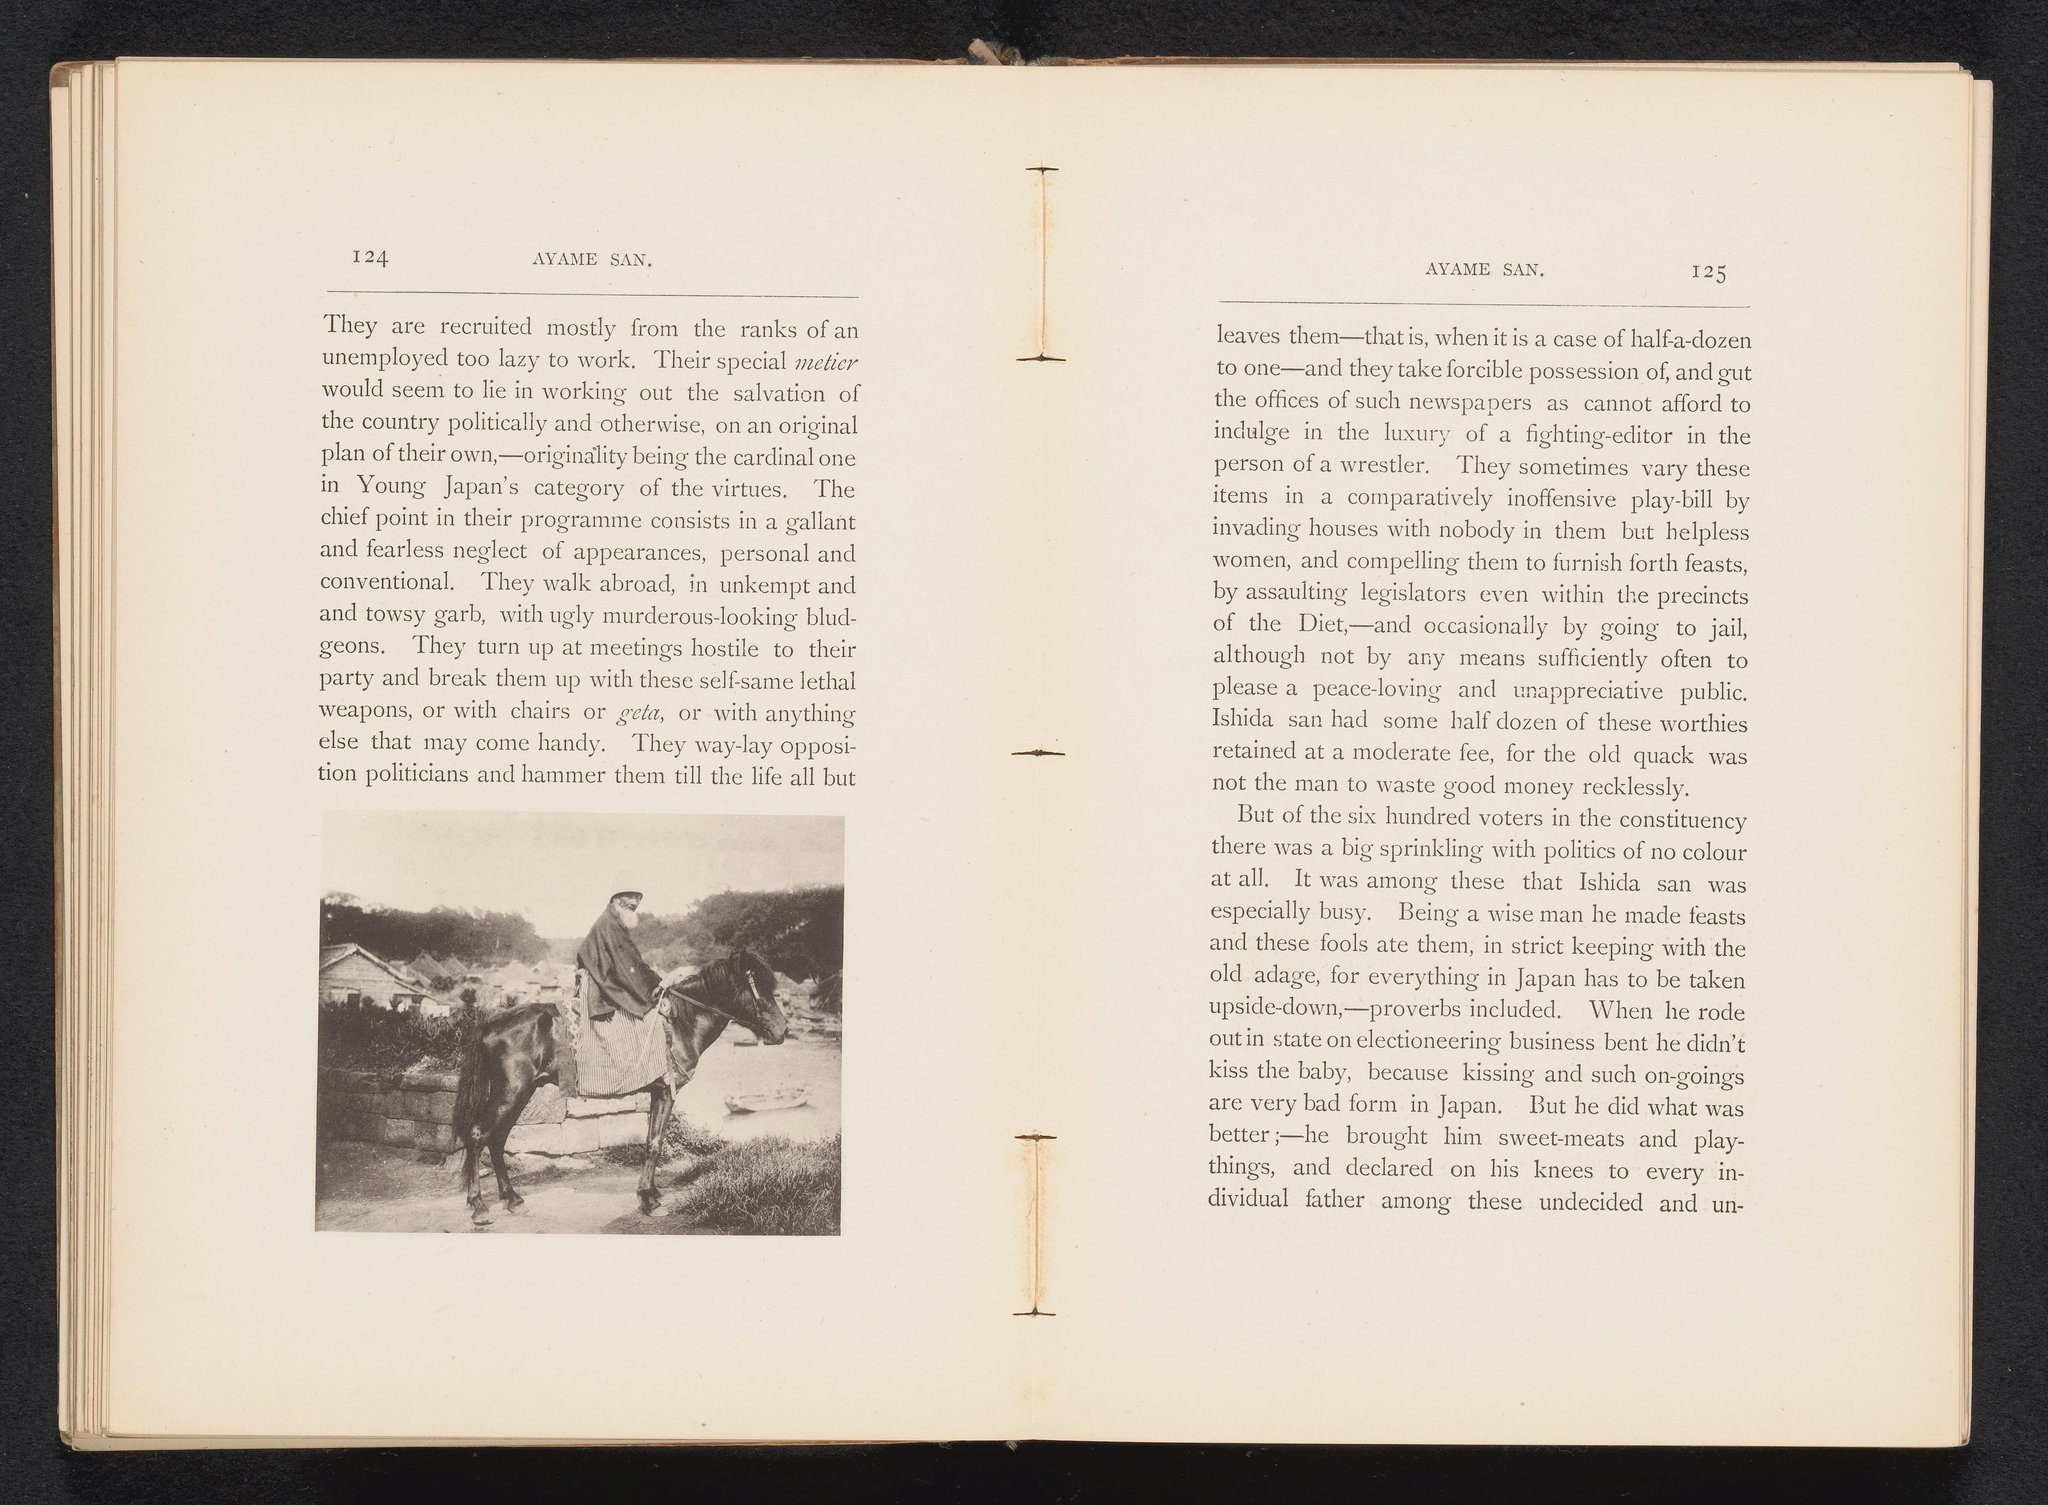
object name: photomechanical print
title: Man op een paard in een dorp te Japan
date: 1882-1892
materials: paper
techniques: photograph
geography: japan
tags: riding a horse, ass, or mule; rider, horseman, façade (of house or building)